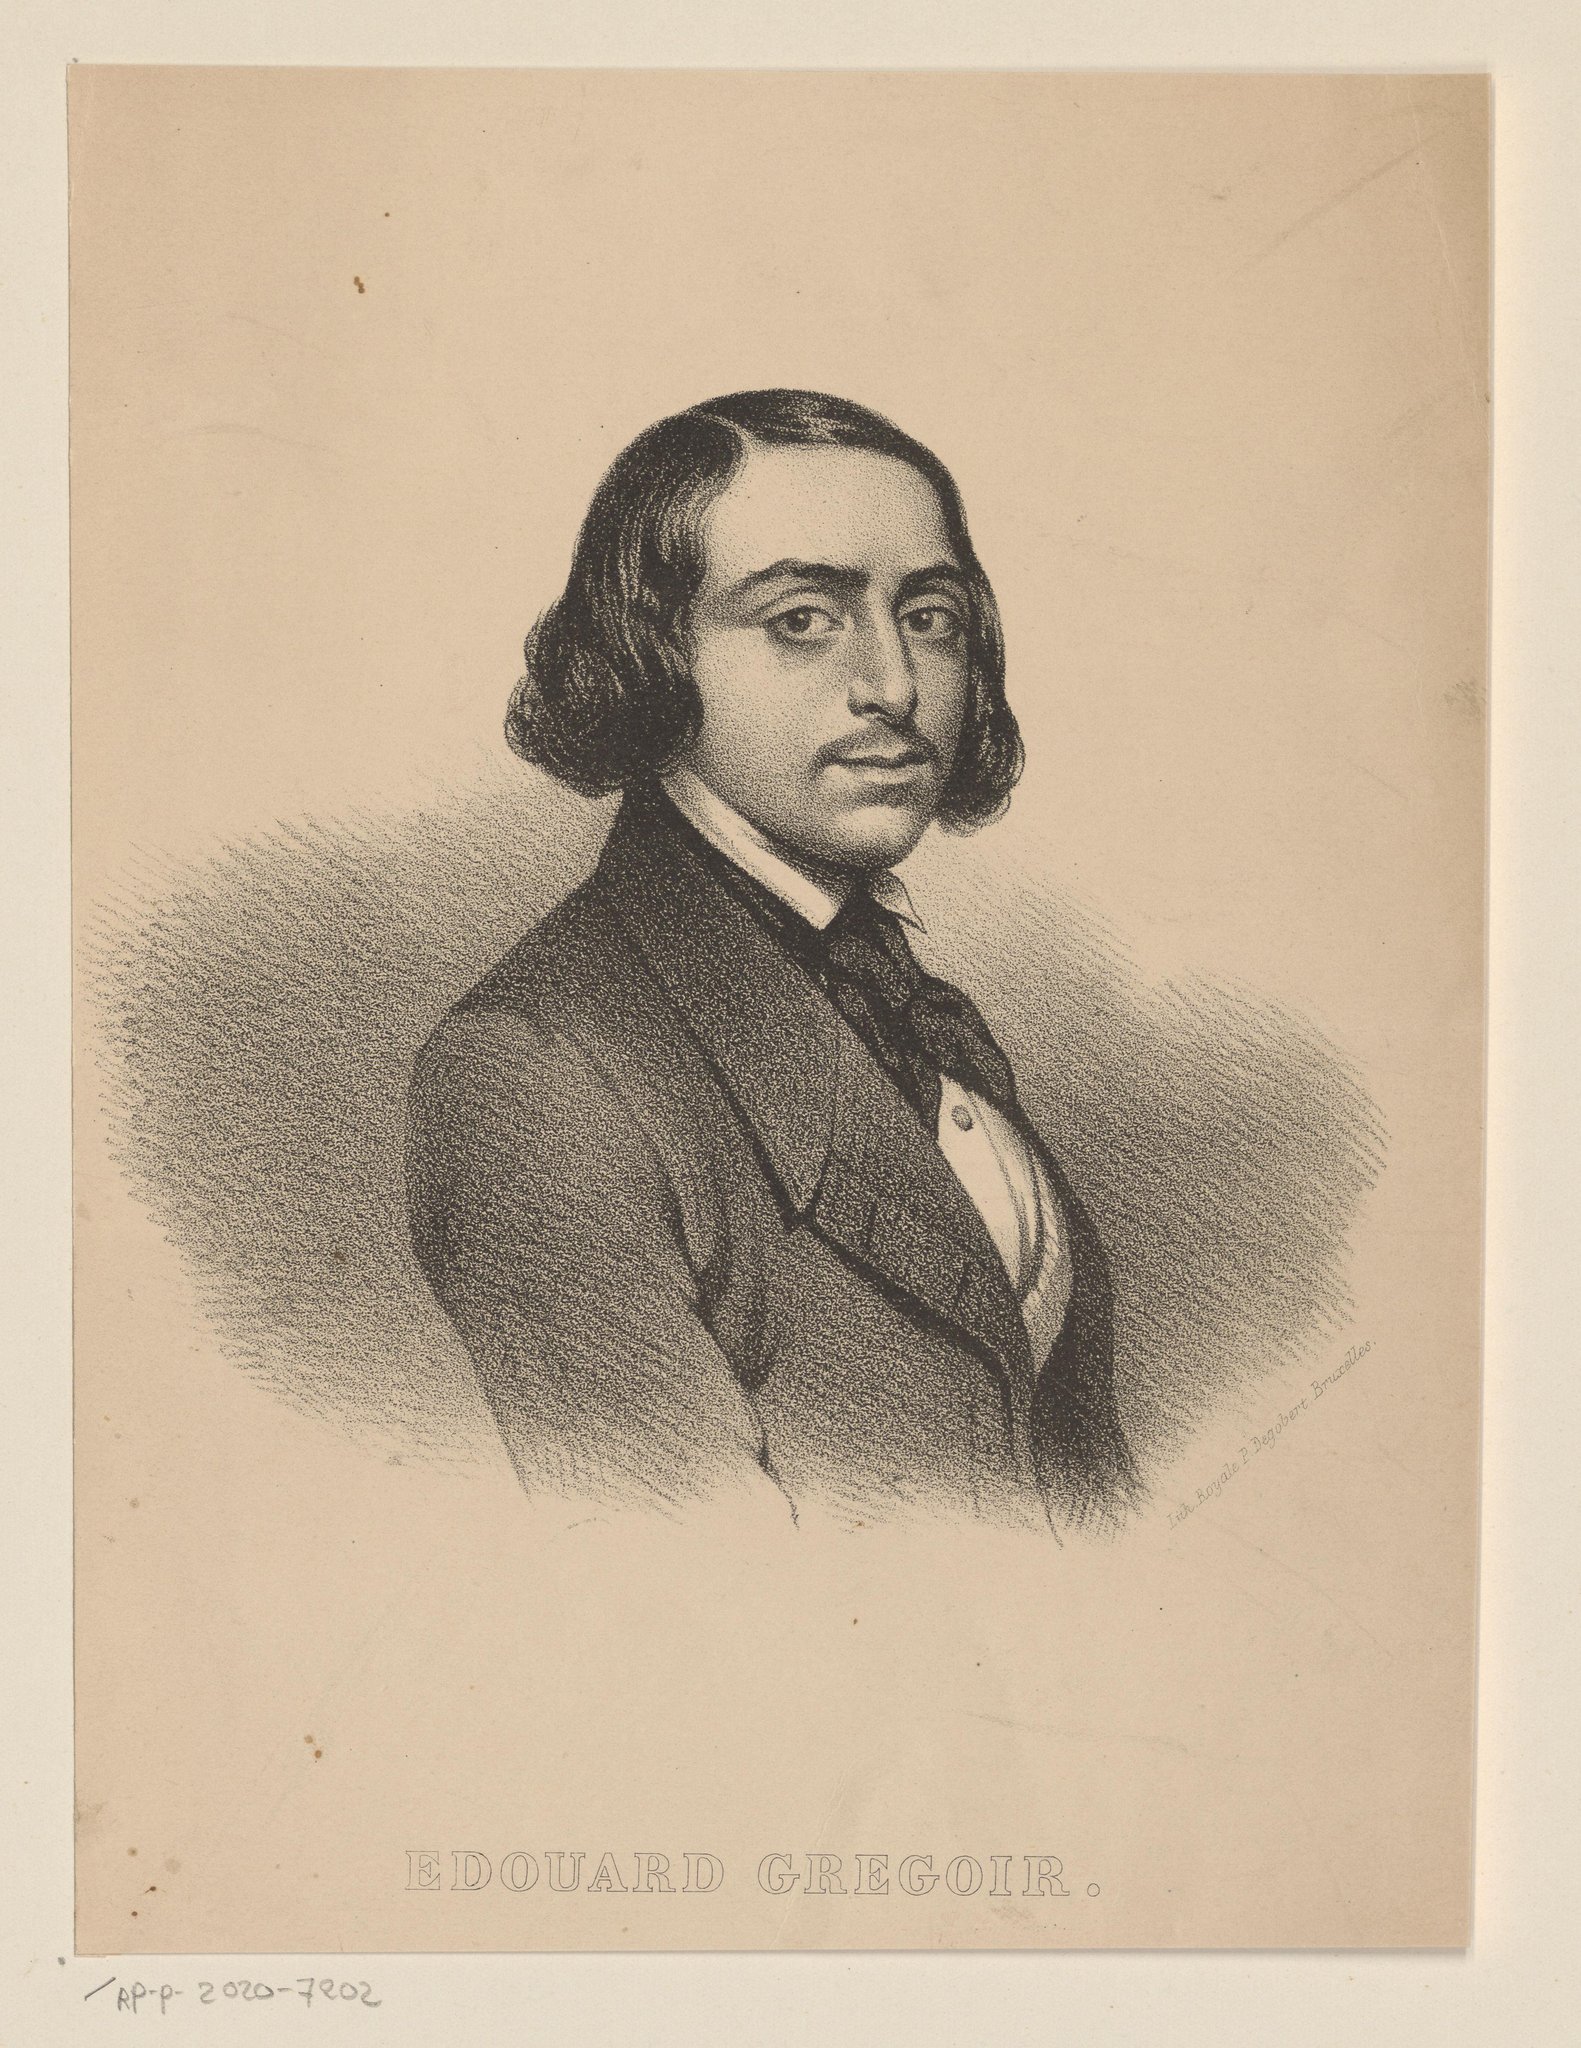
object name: print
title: Portret van Edouard Gregoir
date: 1844-1849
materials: paper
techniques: lithograph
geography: brussels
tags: historical persons, portrait of composer